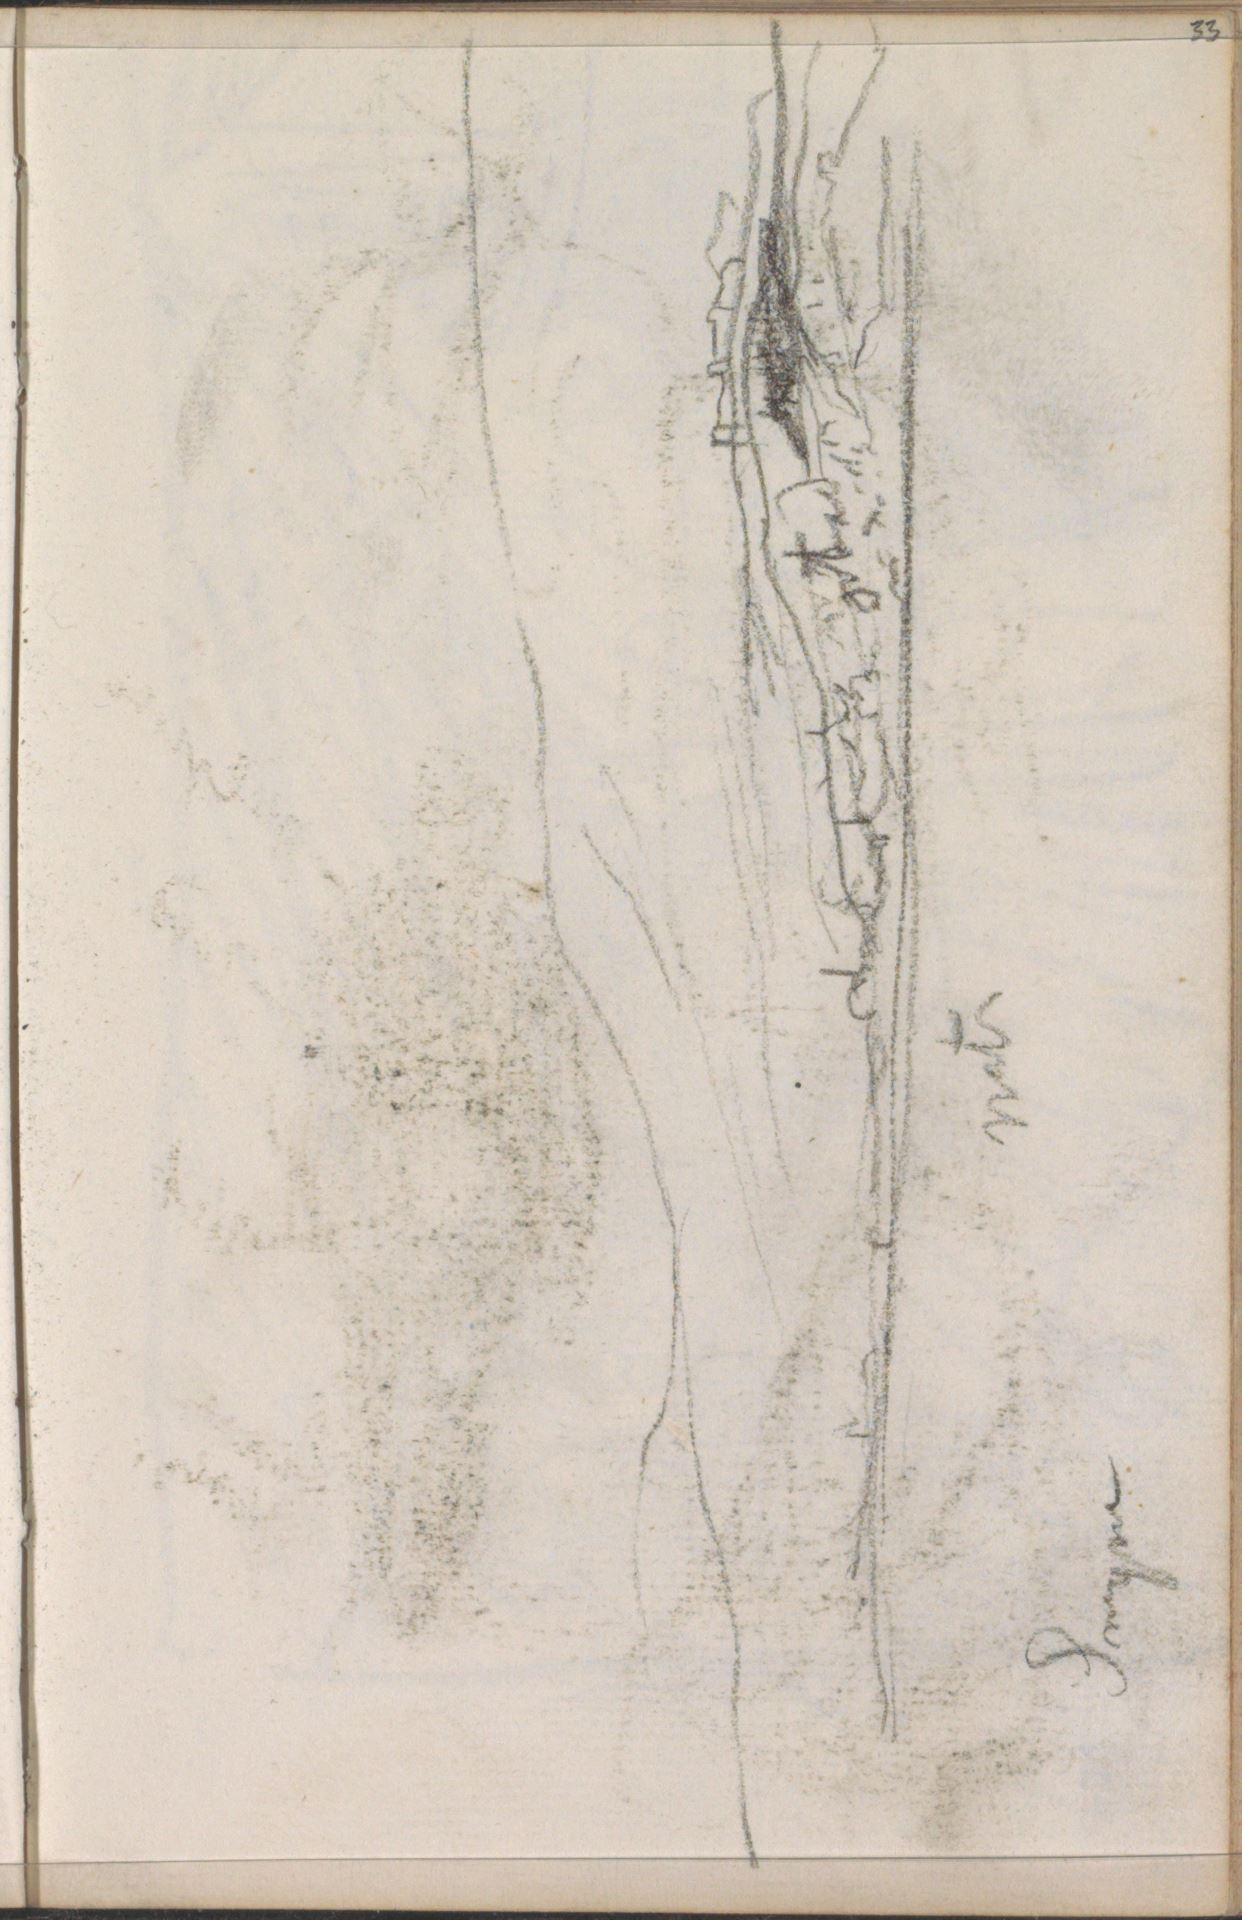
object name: sketchbook leaf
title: Gezicht op Smyrna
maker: marius bauer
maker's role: draughtsman, print maker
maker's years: 1867-1932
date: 1899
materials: chalk, paper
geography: turkey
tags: city-view, and landscape with man-made constructions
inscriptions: annotation: ‘stad/ Smyrna’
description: Pagina 33 uit een schetsboek met 42 bladen.